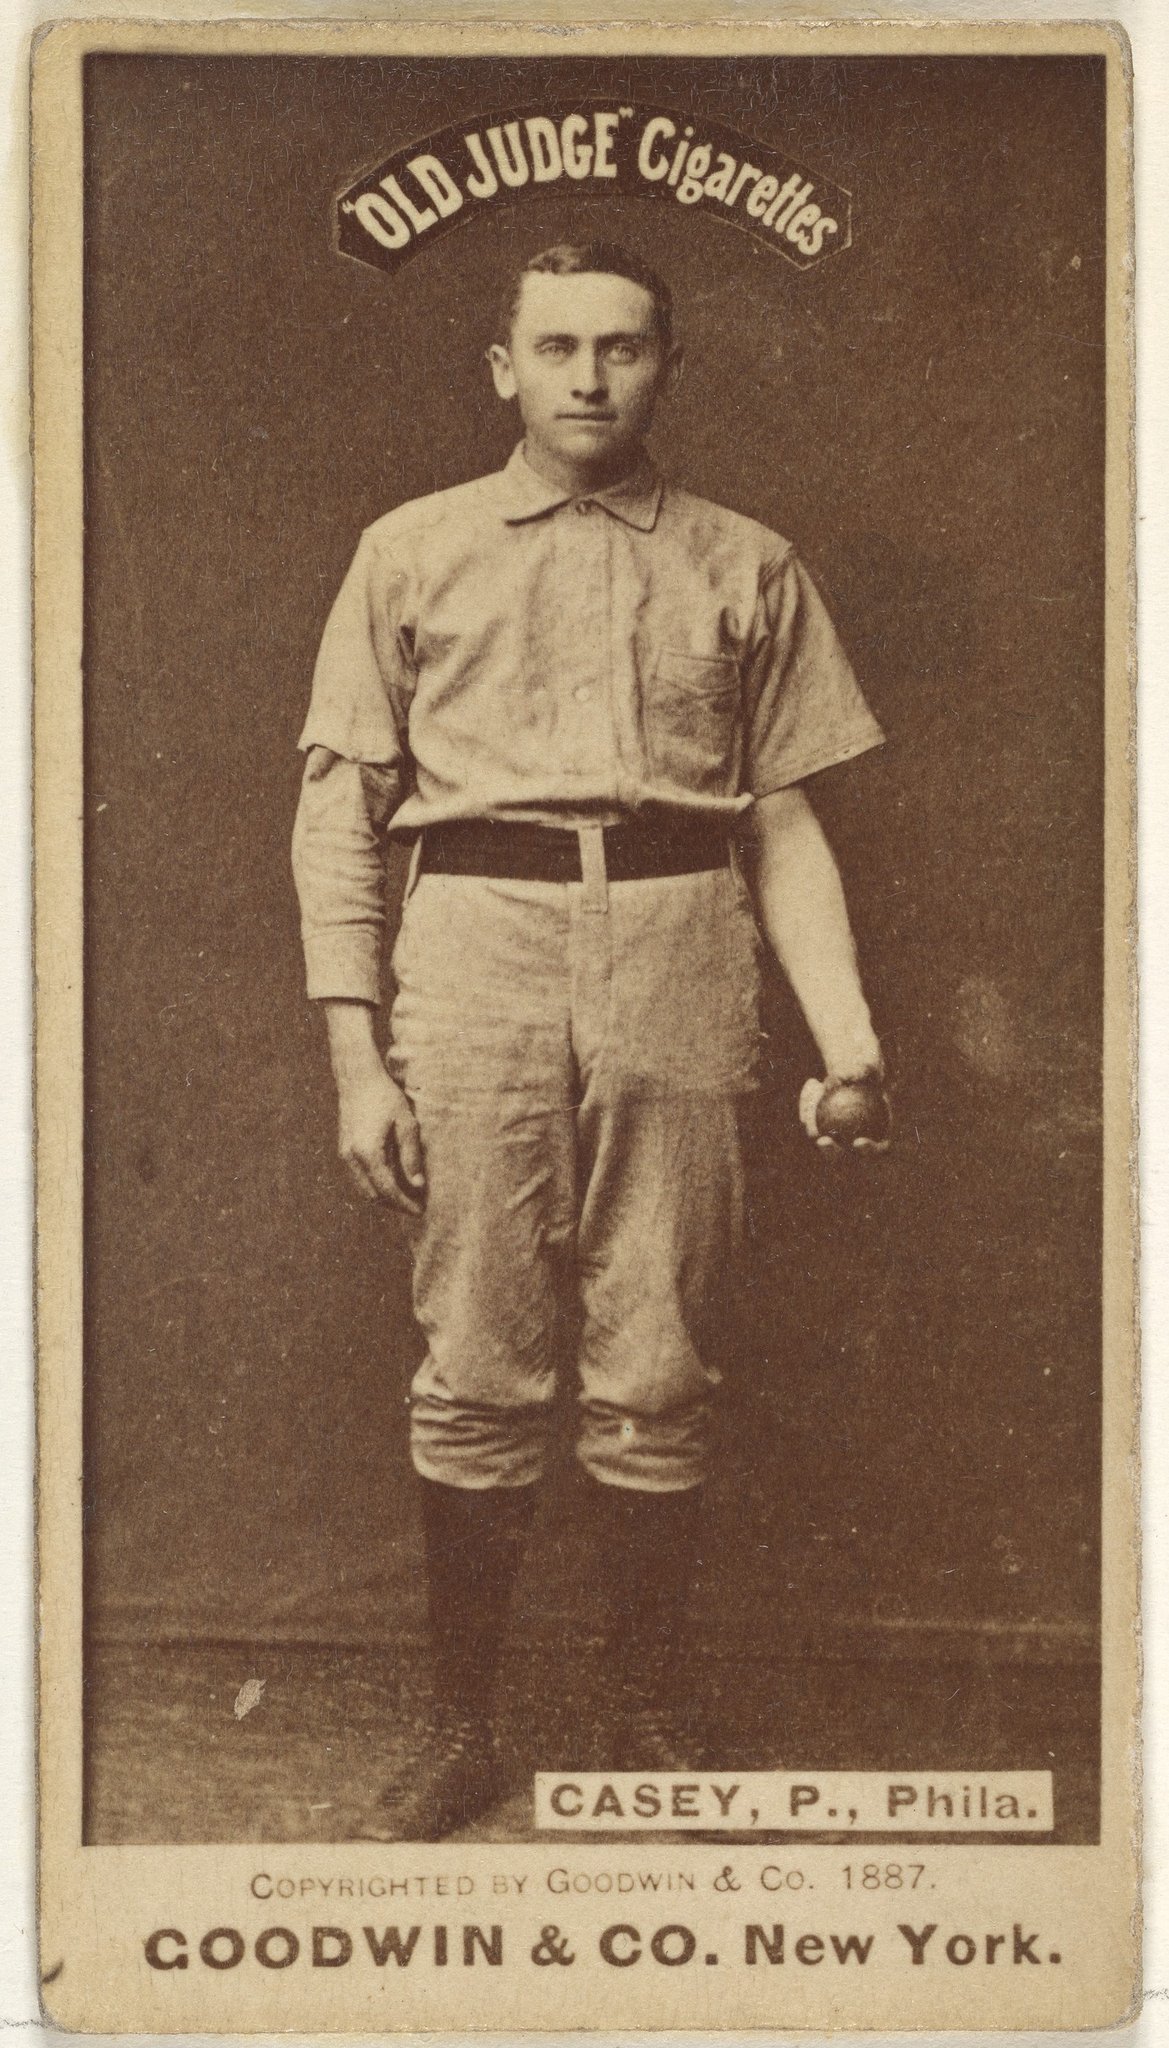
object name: baseball card, photograph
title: Dan Casey, Pitcher, Philadelphia, from the Old Judge series (N172) for Old Judge Cigarettes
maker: goodwin & company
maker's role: publisher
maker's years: 1850-1950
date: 1887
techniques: albumen silver print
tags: men,portraits,baseball,athletes